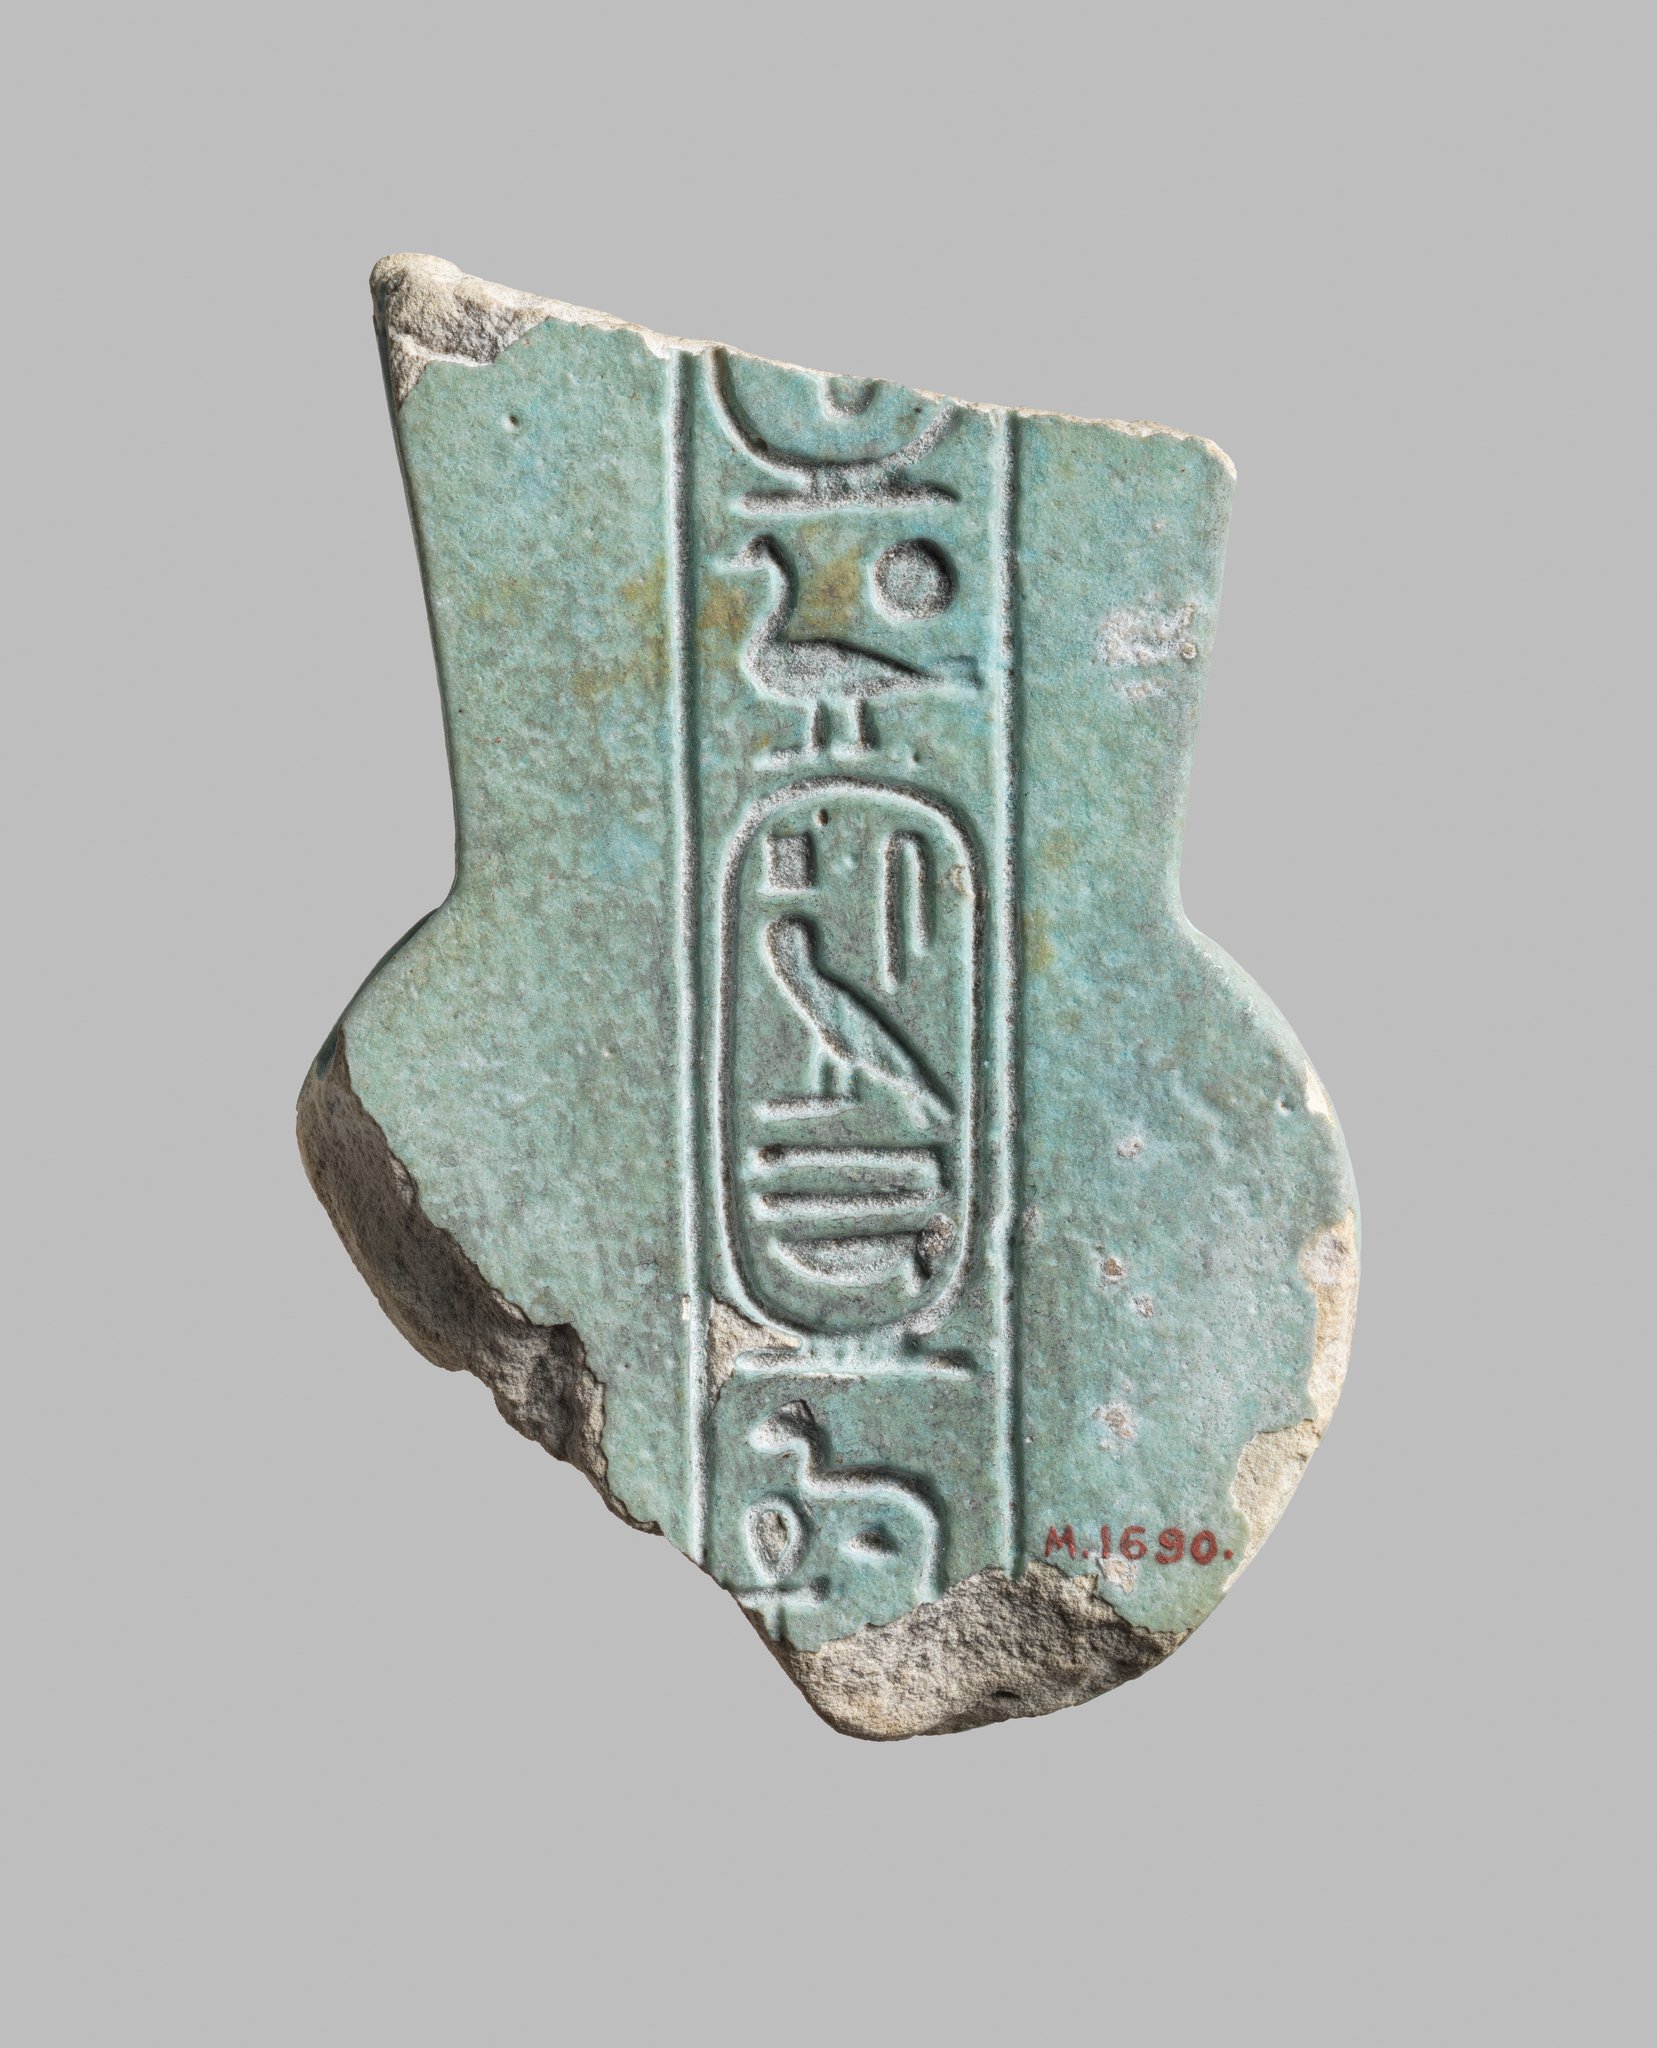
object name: menat fragment, psamtik i or ii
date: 664-589 BCE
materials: limestone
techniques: glazing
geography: egypt